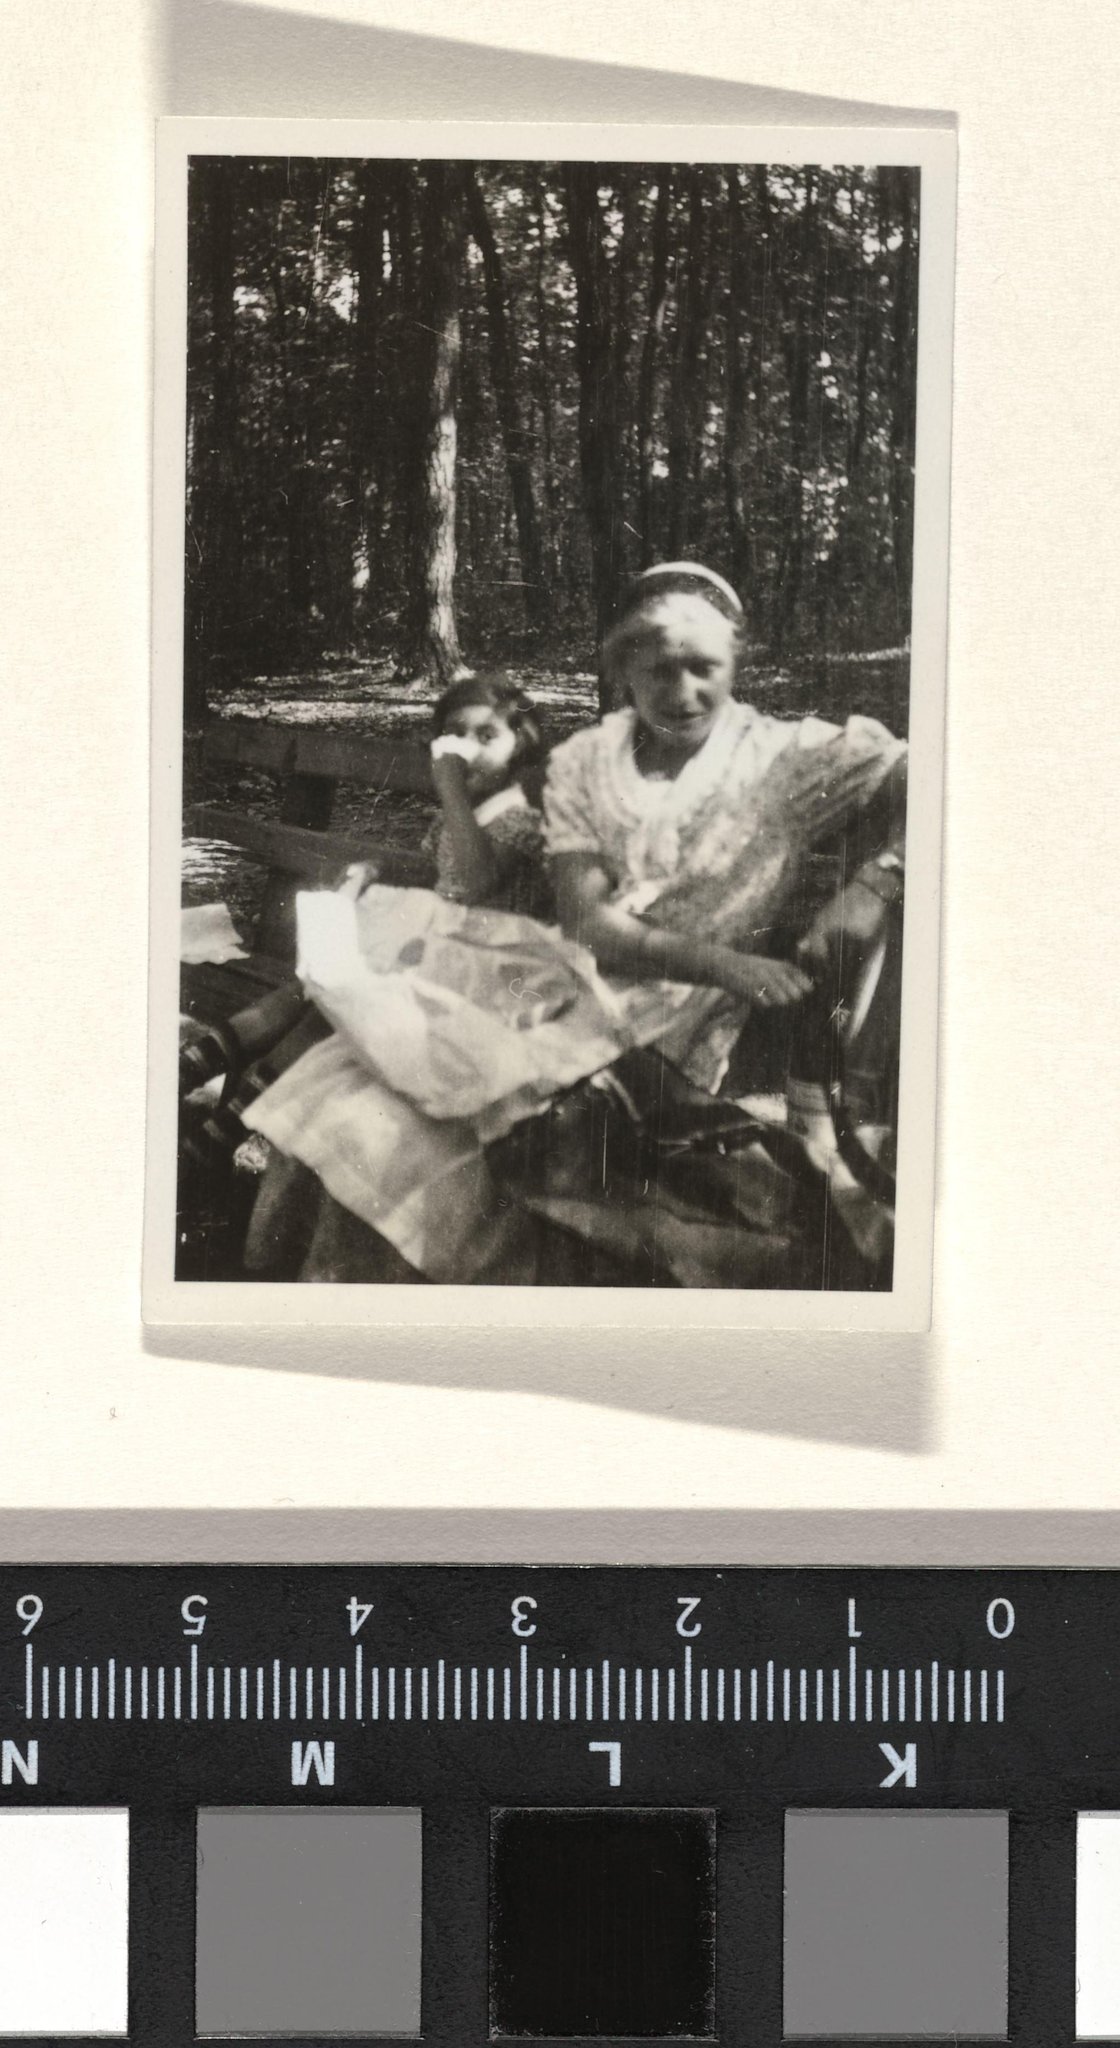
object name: photograph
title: Onbekende vrouw met tas op haar schoot en kind gezeten op een bankje in een bosrijke omgeving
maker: Anonymous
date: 1920-1950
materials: photographic support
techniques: gelatin silver print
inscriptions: company name: ‘Photo Rieger ROtebühlstr. 90 1331’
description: Onbekende vrouw (rechts) met tas op haar schoot en kind (links) gezeten op een bankje in een bosrijke omgeving.